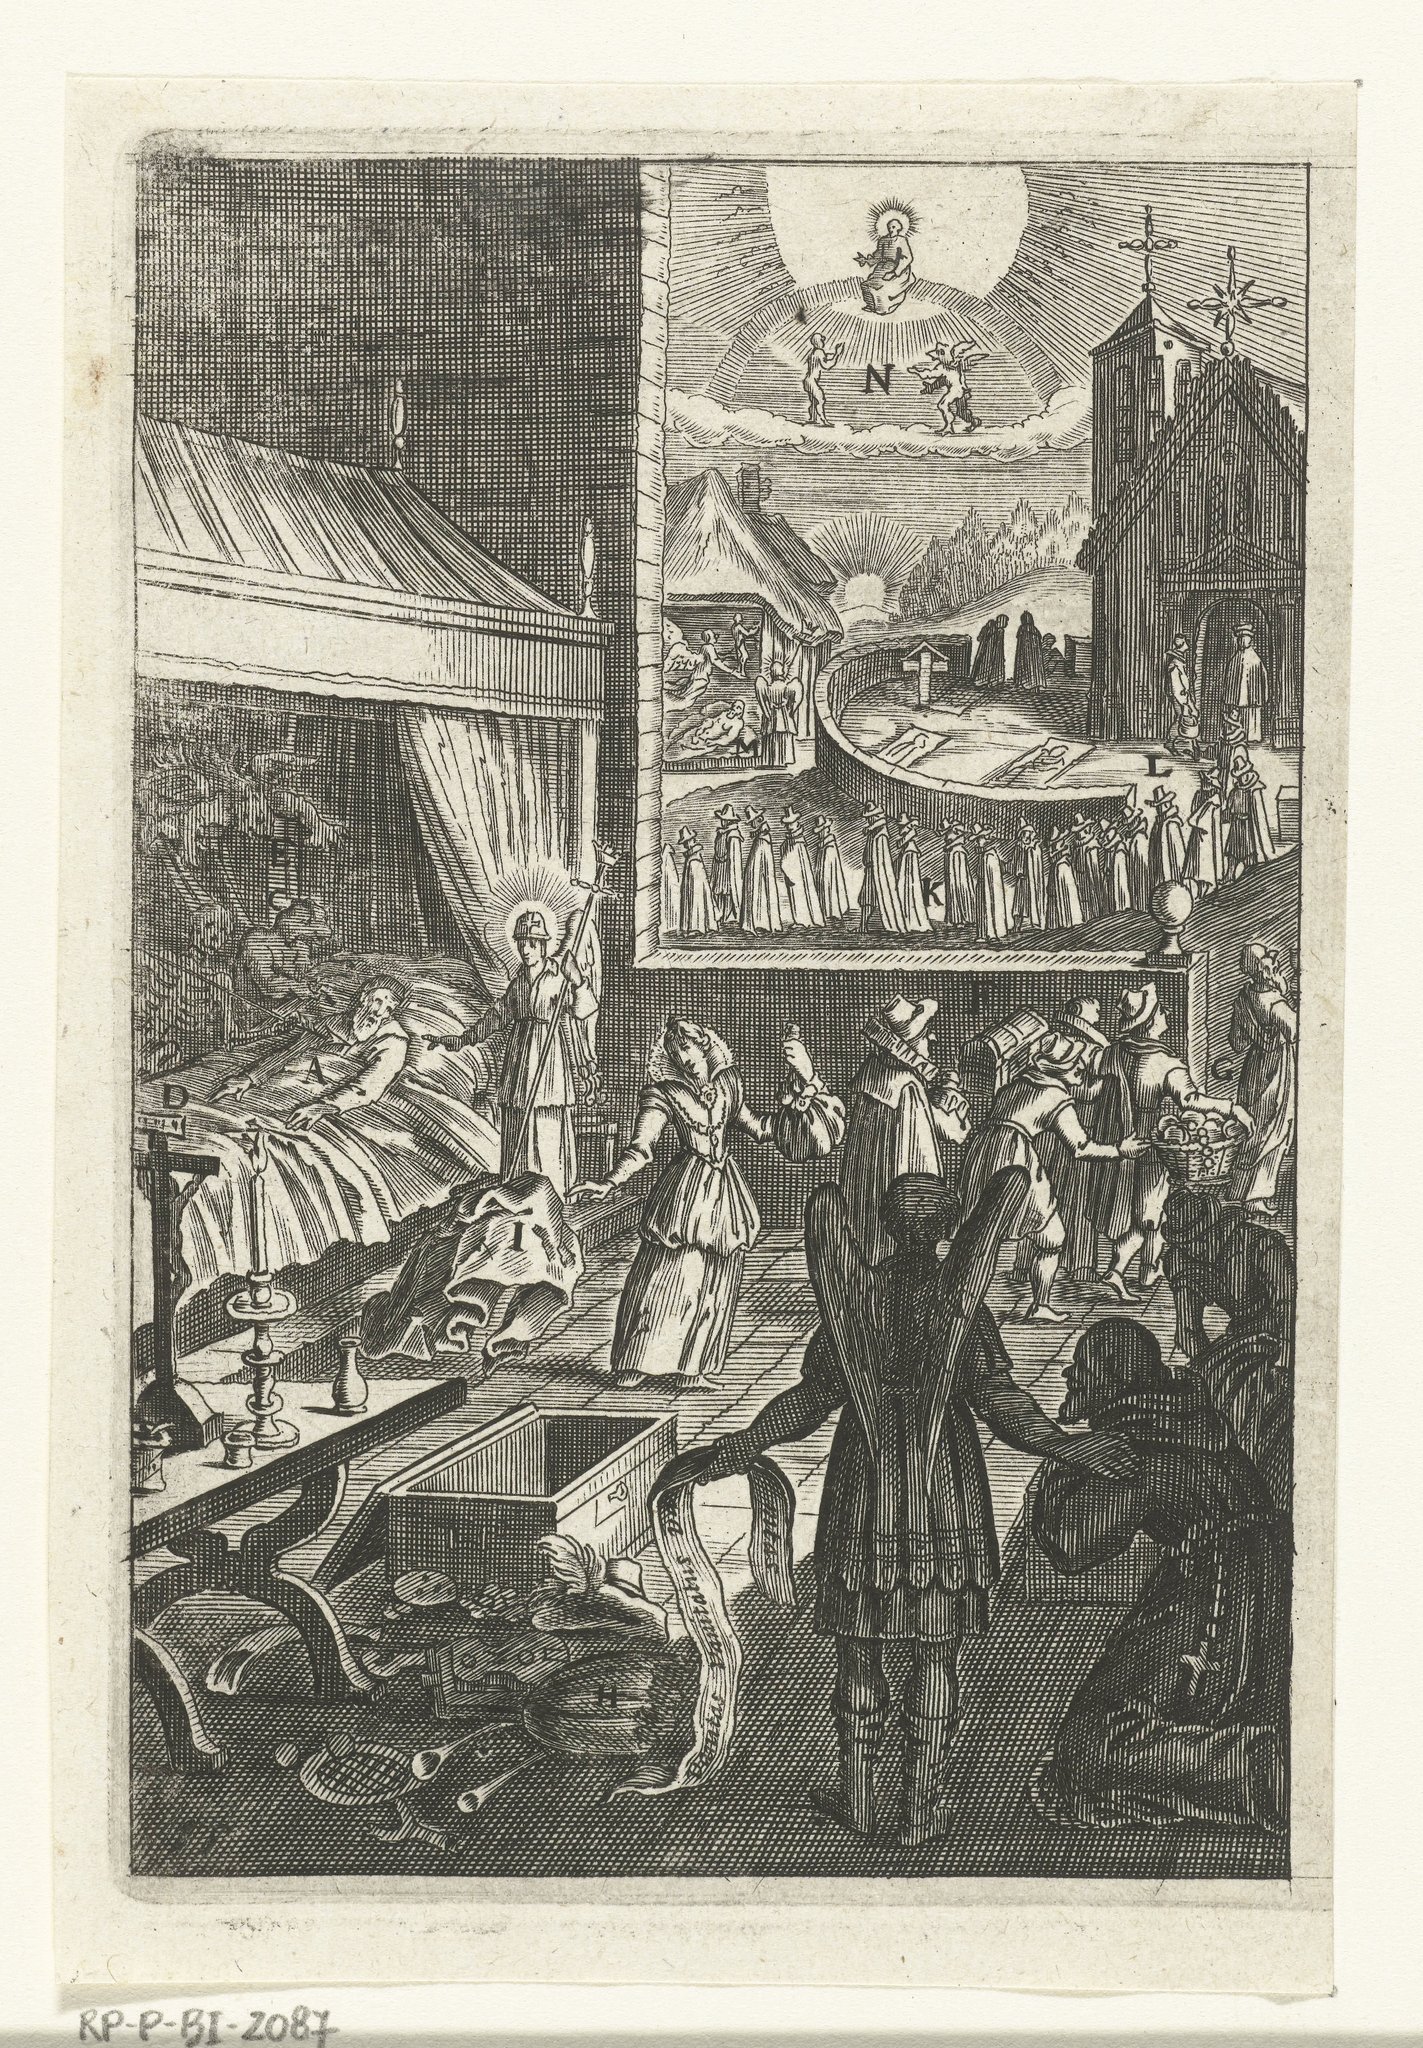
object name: book illustration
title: Den wech des eeuwich levens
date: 1620-1649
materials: paper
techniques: engraving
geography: antwerp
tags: the life of man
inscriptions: collector's mark: Lugt 2228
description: Een engel toont een geestelijke een dode man in zijn bed. De Dood en de duivel komen zijn ziel halen terwijl zijn vrienden en familie hem in de steek laten en er met zijn rijkdommen vandoor gaan. Met een leven in deugd daarentegen kan de man met een gerust hart de dood tegemoet zien.